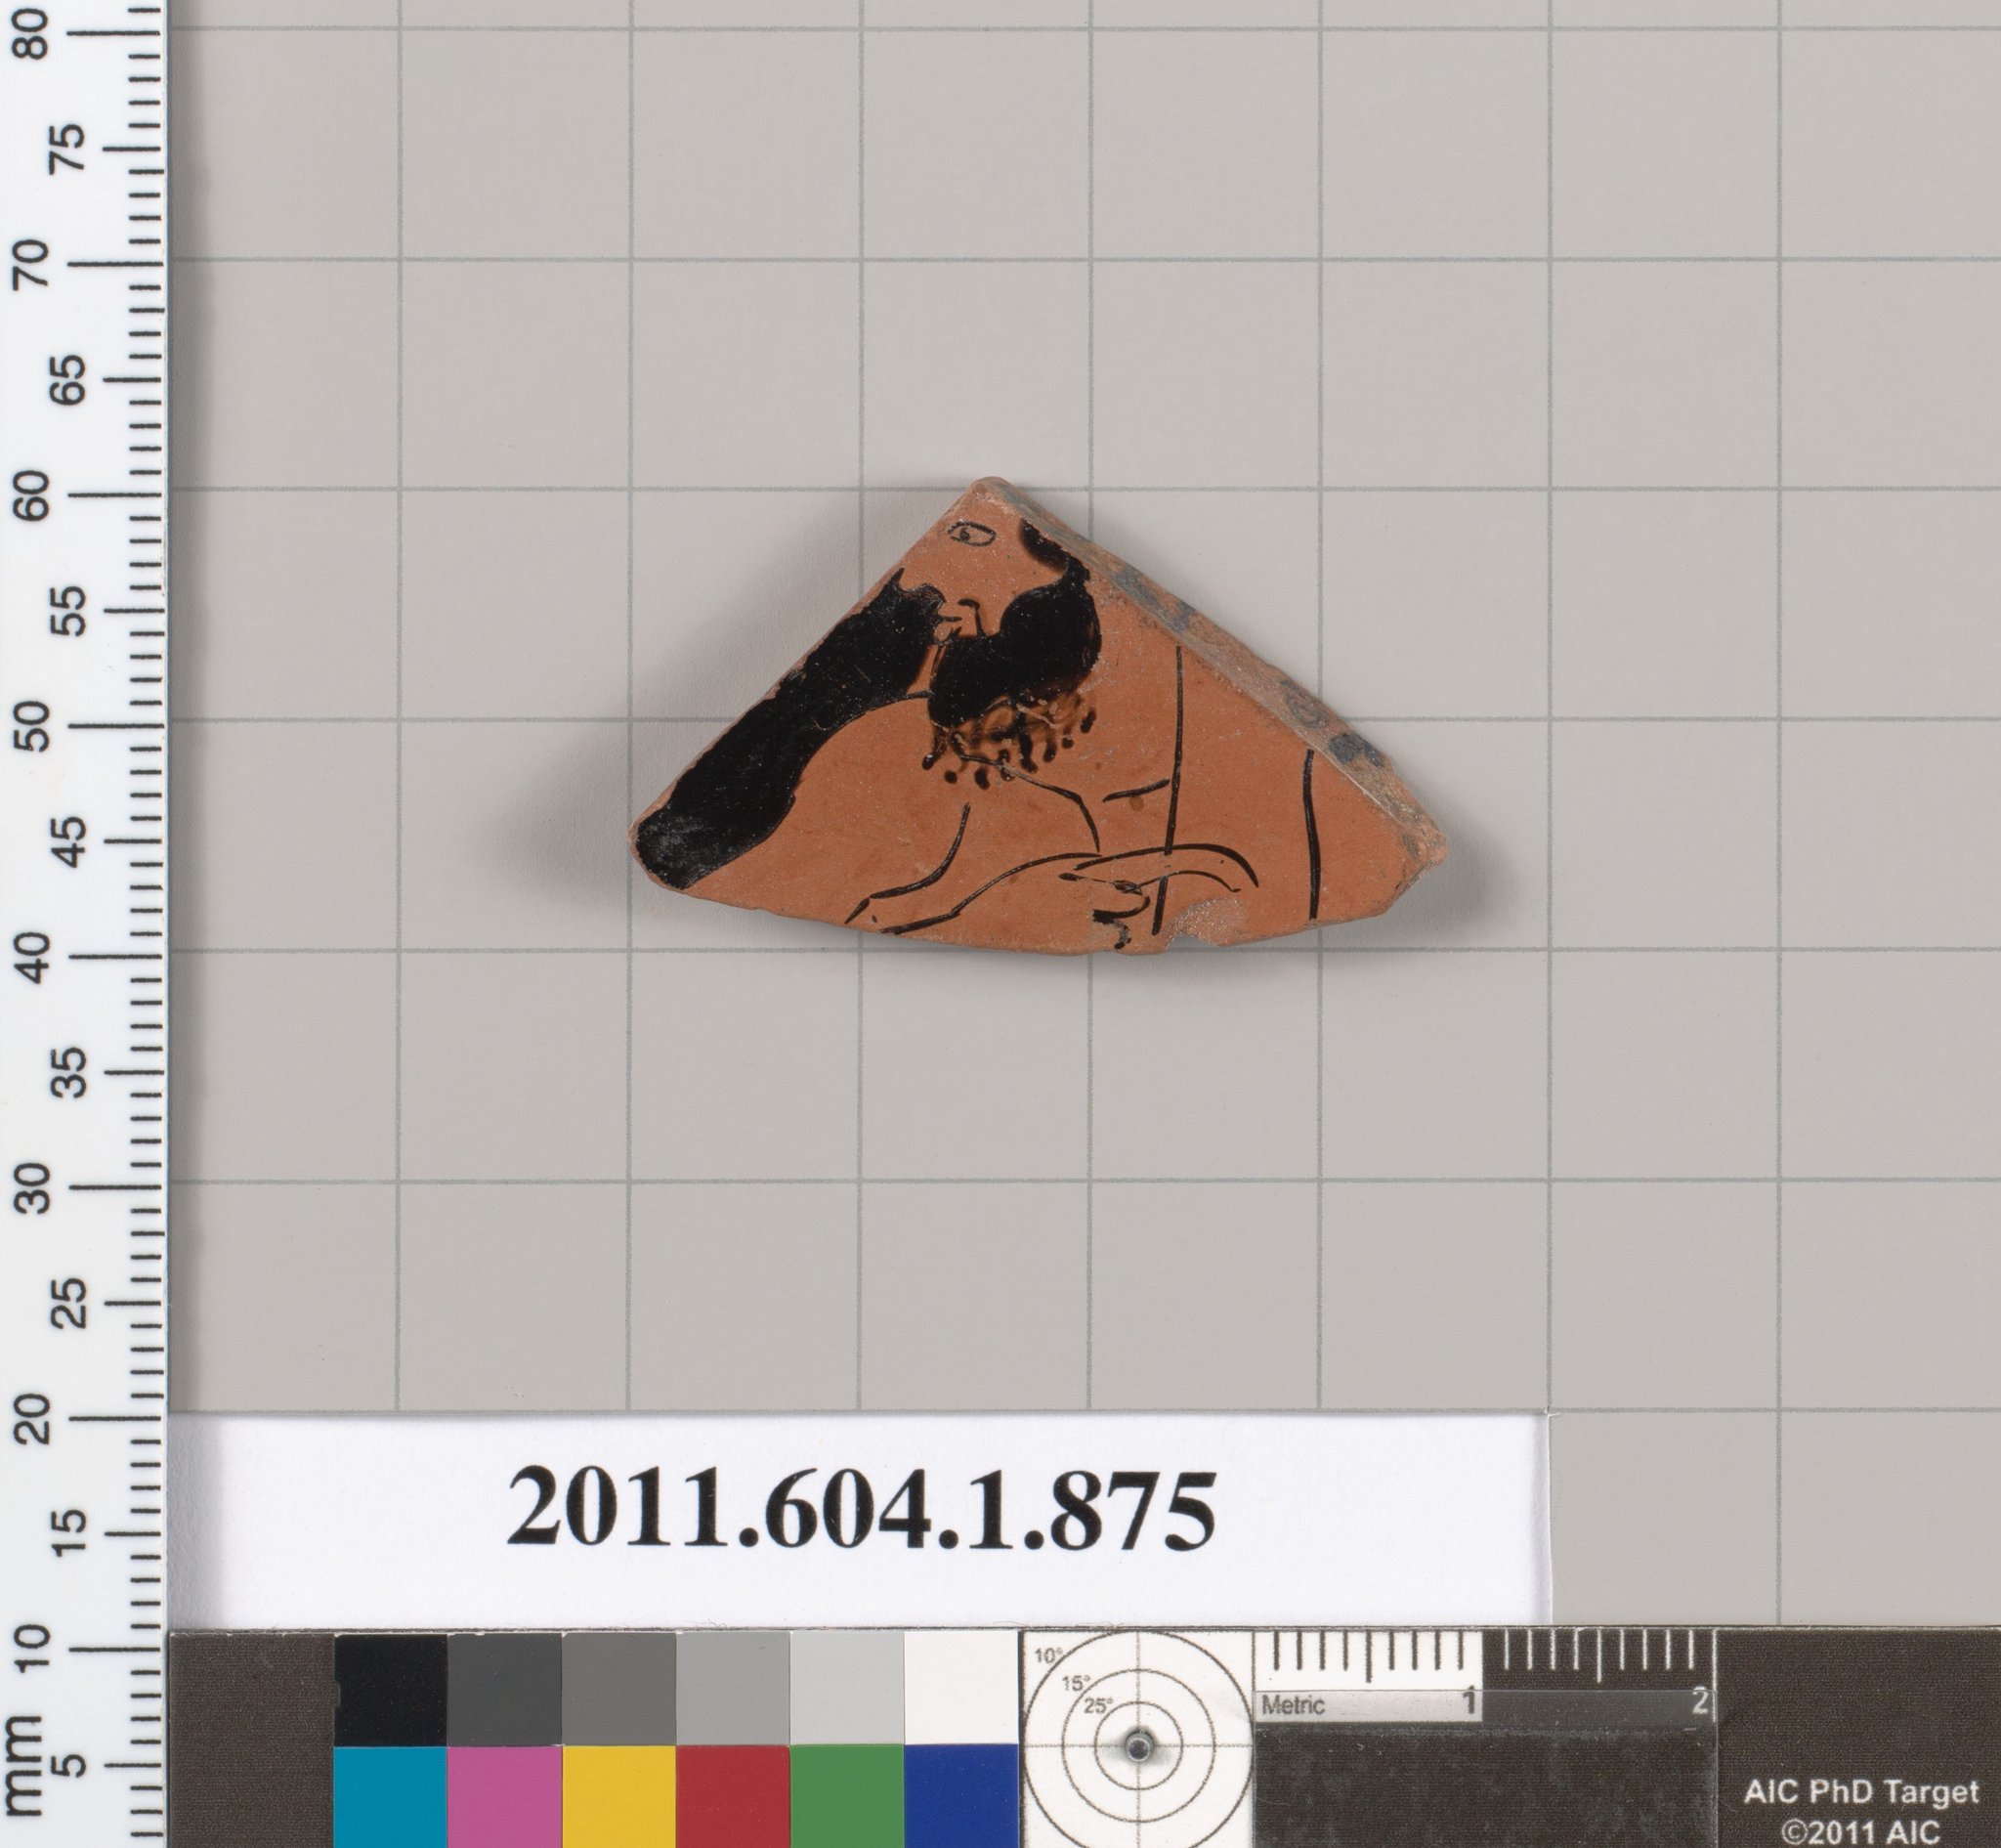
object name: kylix fragment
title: Terracotta fragment of a kylix (drinking cup)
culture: greek, attic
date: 480-470 BCE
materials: terracotta